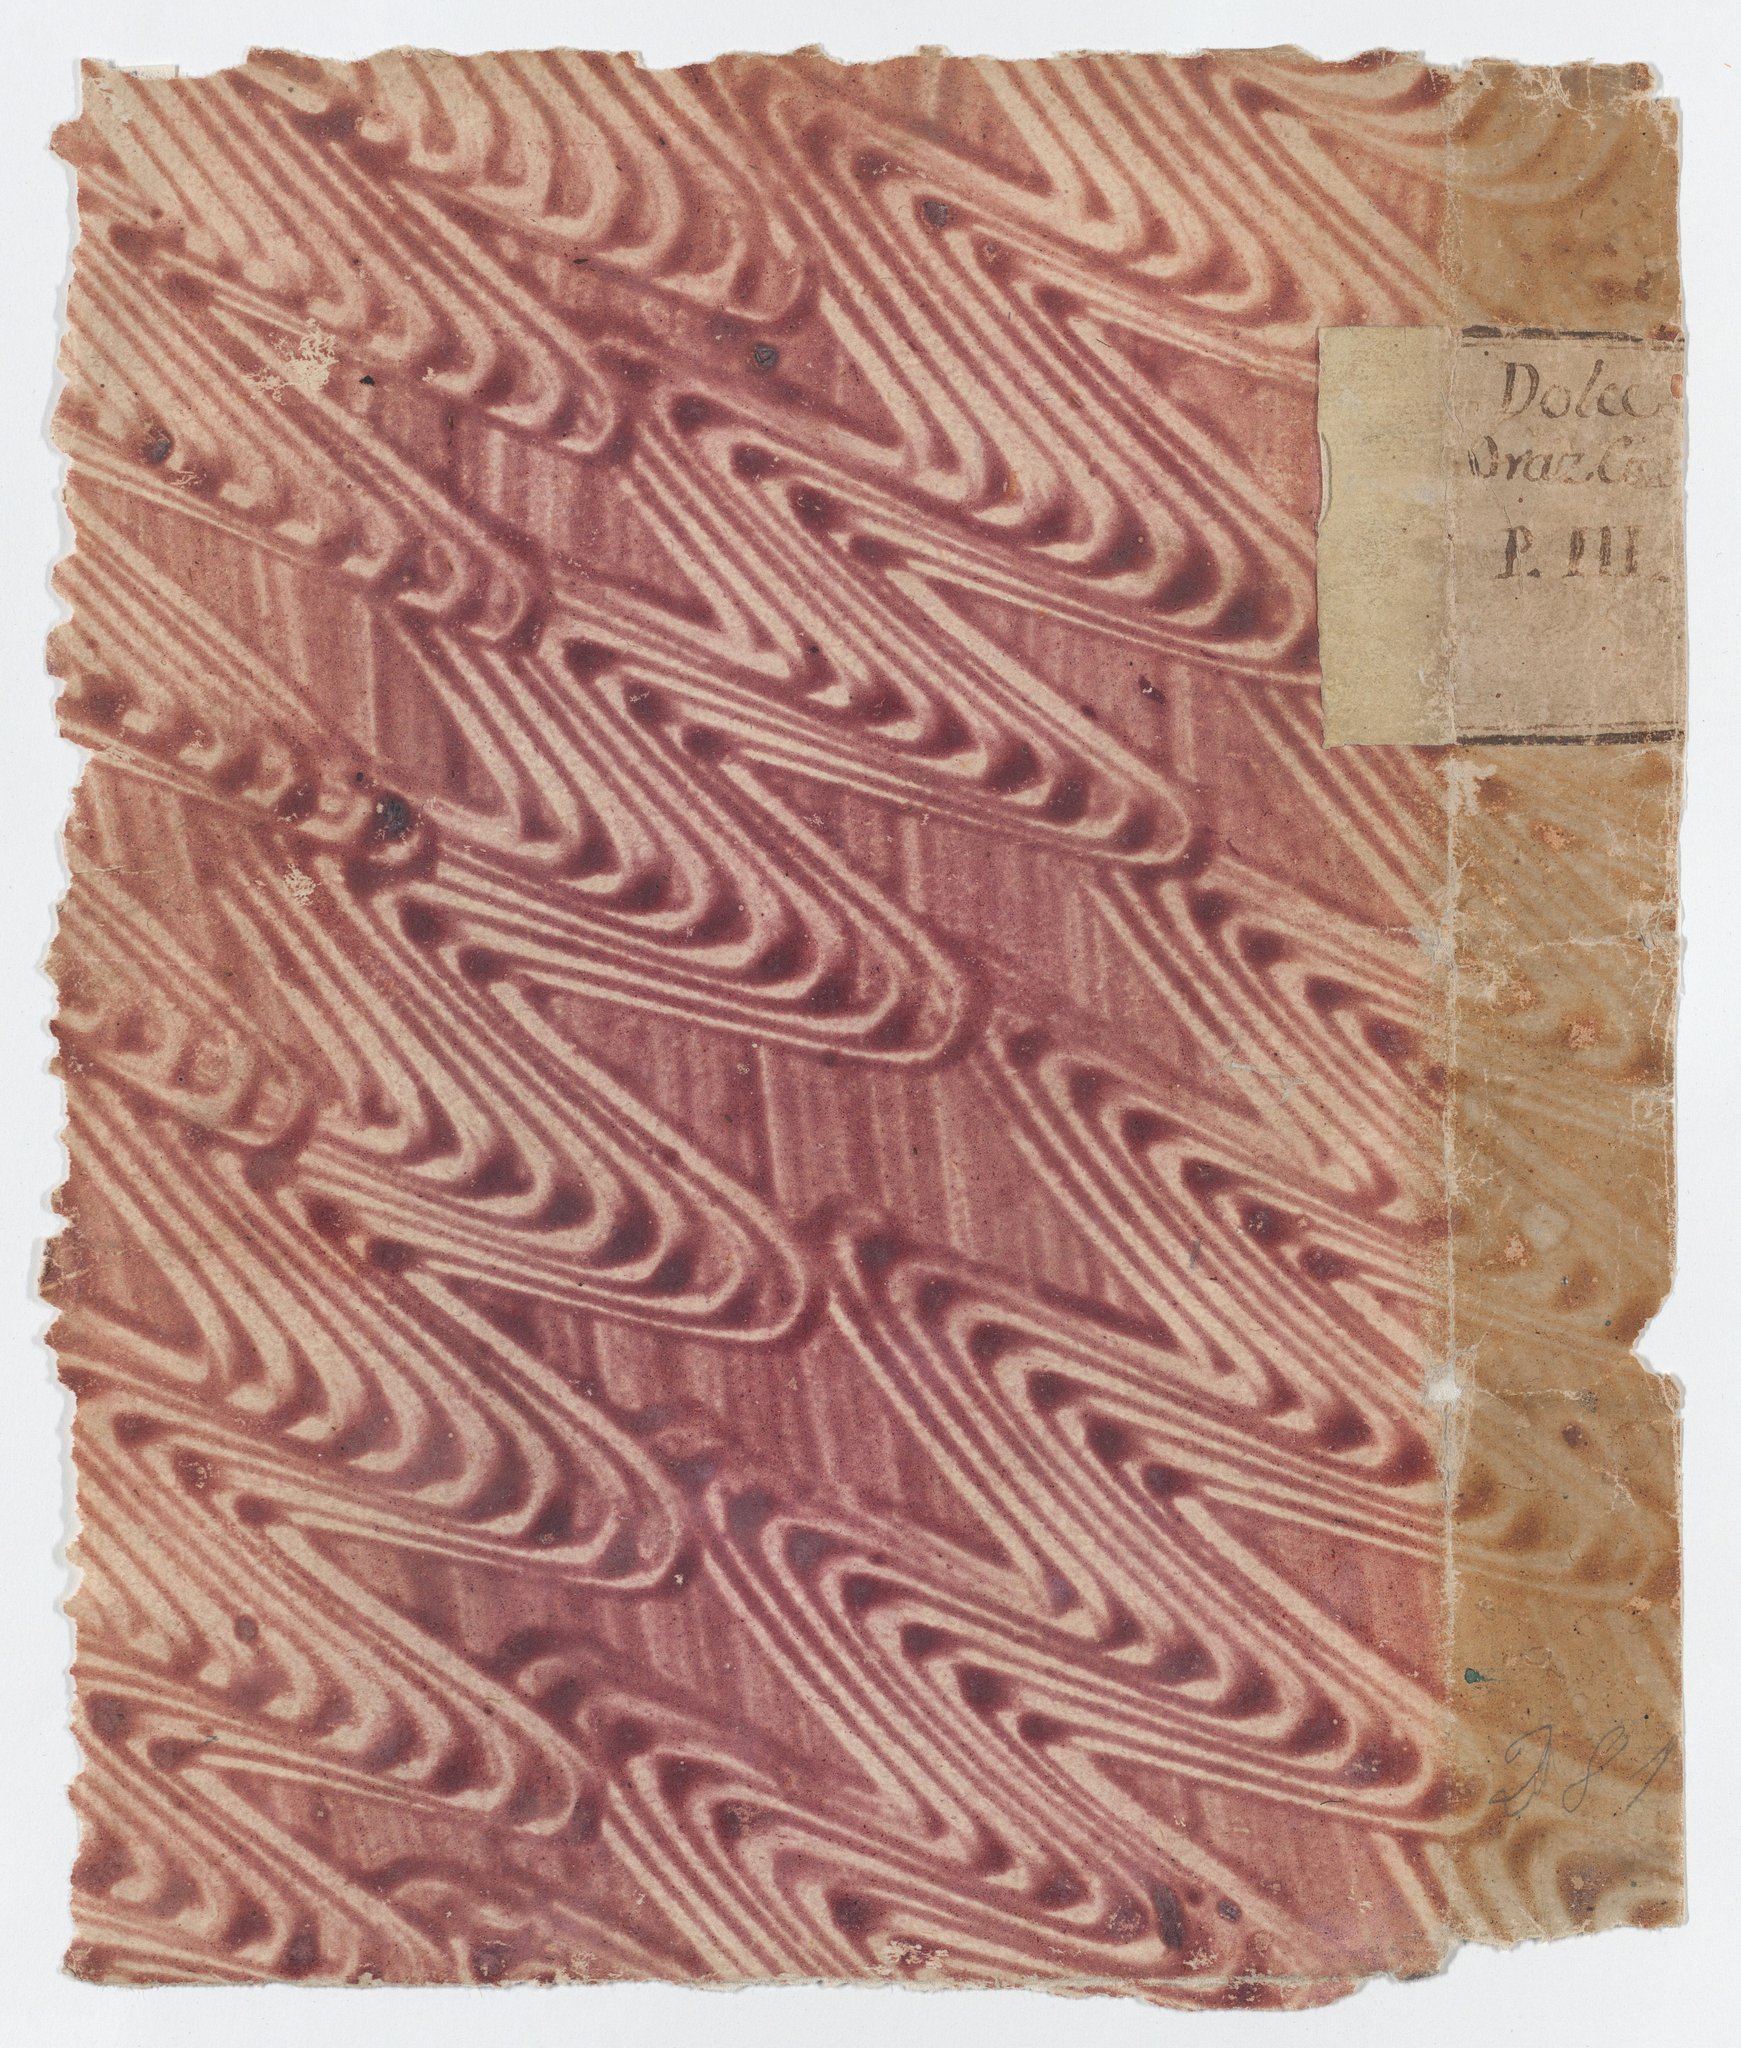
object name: print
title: Red paste paper book cover with curved line design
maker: Anonymous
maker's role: artist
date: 1701-1800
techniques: relief print